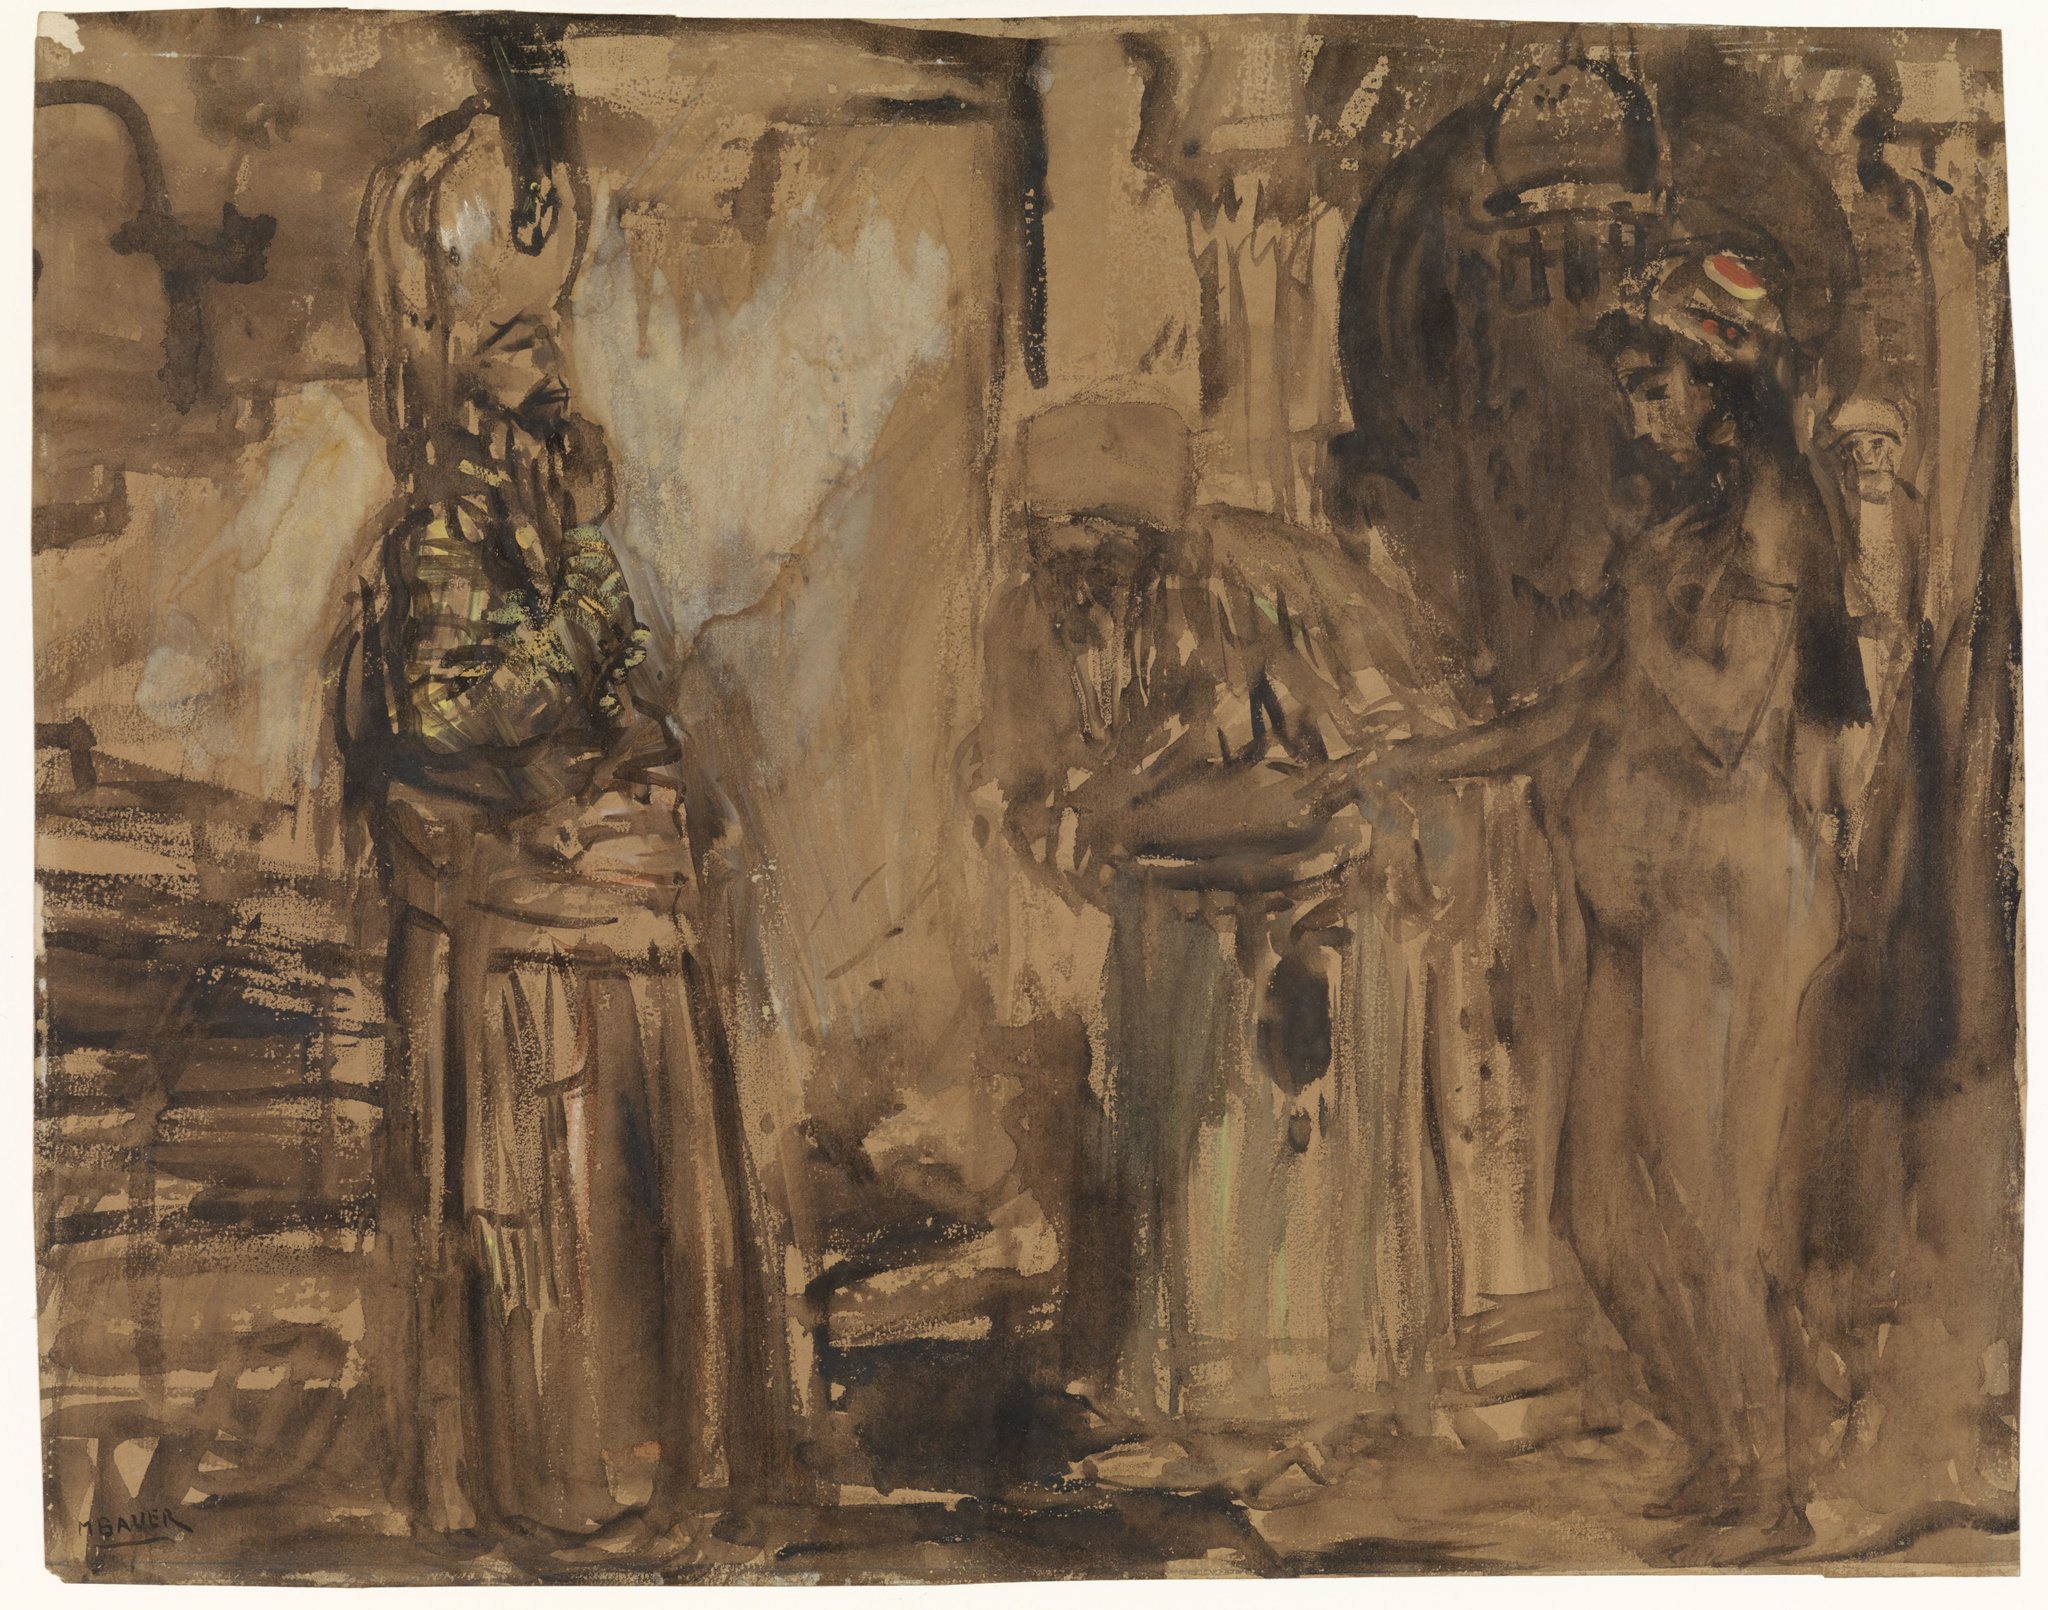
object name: watercolor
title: Slavenhandelaar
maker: marius bauer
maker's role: draughtsman, print maker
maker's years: 1867-1932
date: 1877-1919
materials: ink, paper, watercolor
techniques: brush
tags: slave-trade, standing figure - aa - female human figure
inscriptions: signature: ‘M Bauer’